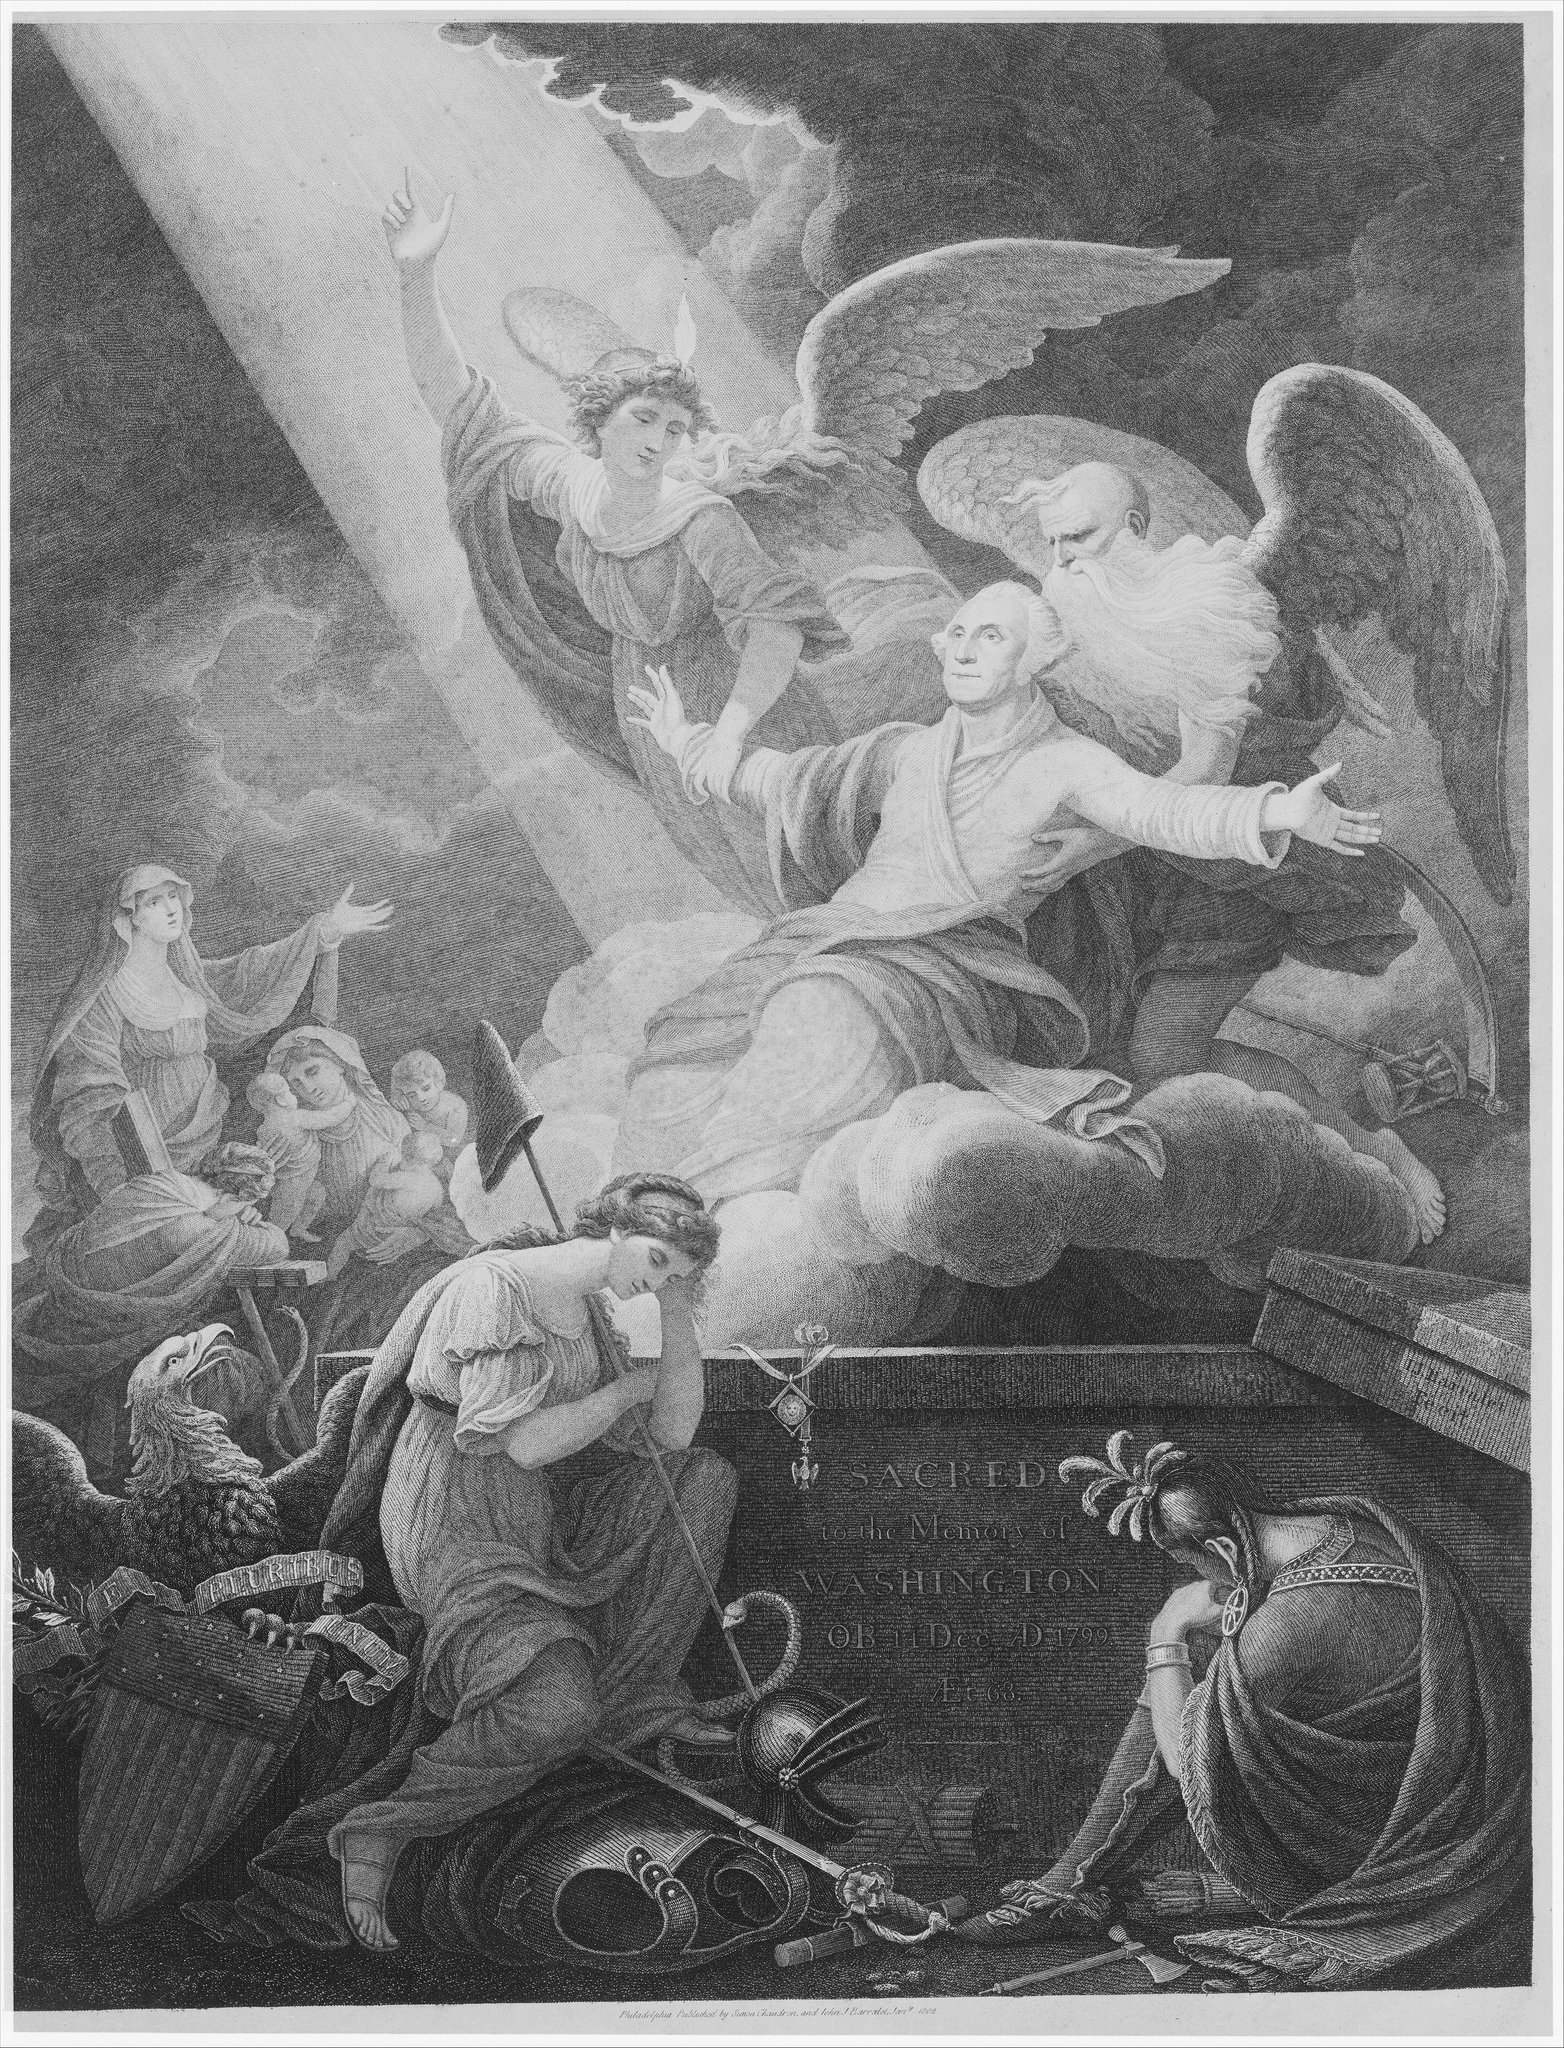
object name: print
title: Apotheosis of Washington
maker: john james barralet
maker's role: artist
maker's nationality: irish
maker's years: 1747-1815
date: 1800-1802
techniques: engraving, etching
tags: eagles,george washington,women